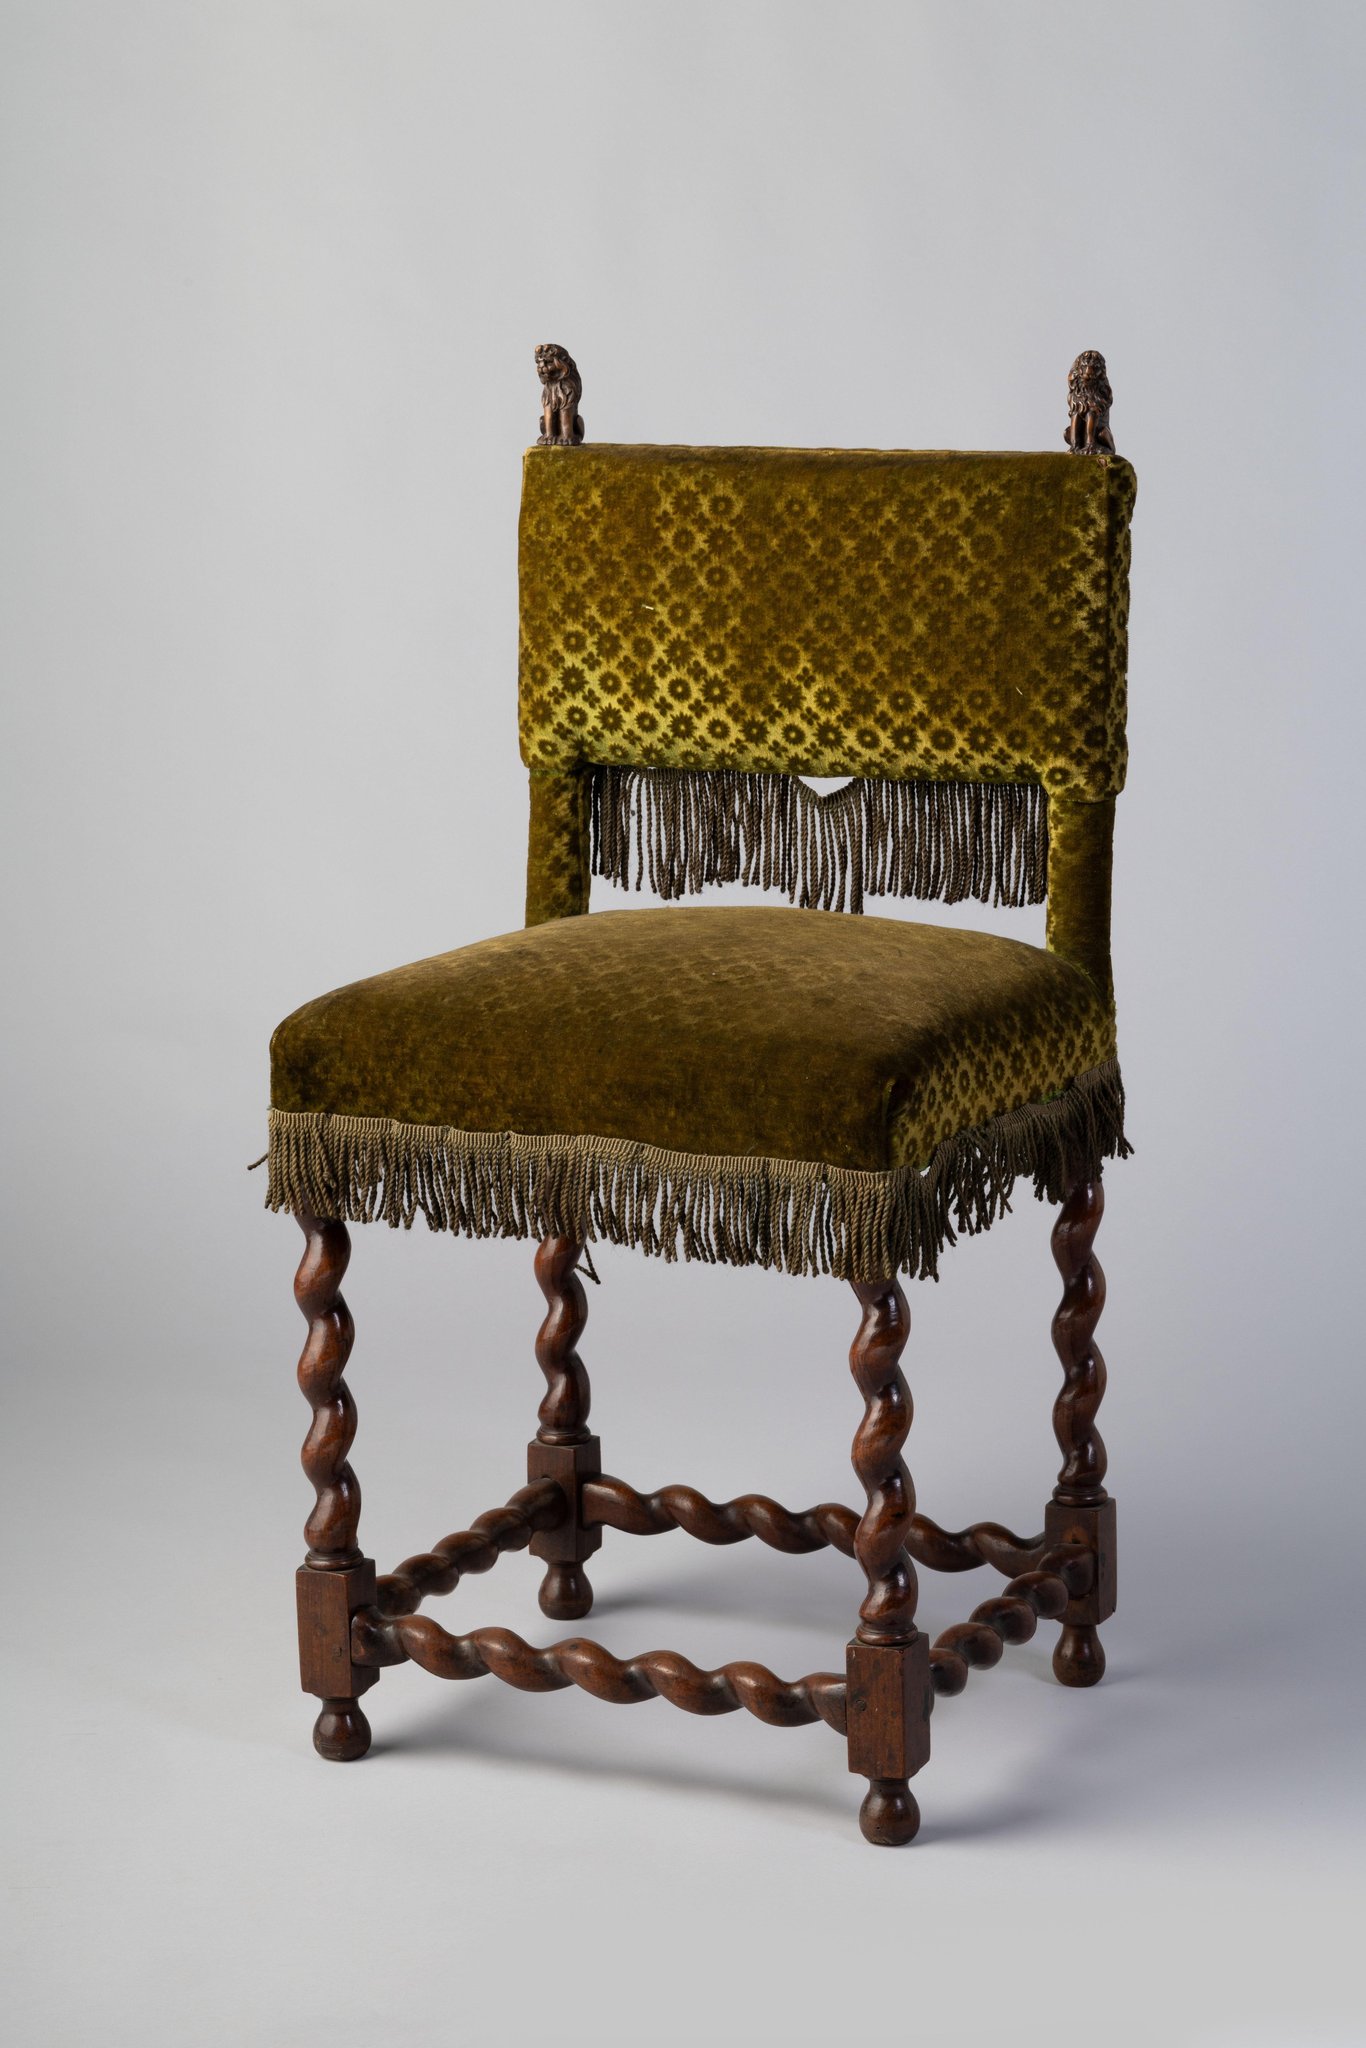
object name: chair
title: Stoel van notenhout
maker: Anonymous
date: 1640-1660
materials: textile, wood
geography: netherlands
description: Stoel van notenhout. Het meubel is bekleed en heeft geslingerde poten, verbonden door vier plat geslingerde ondersporten. De achterstijlen, tussen zitting en rug, zijn mede bekleed en bekroond door twee losse gestoken leeuwtjes, zonder basement.